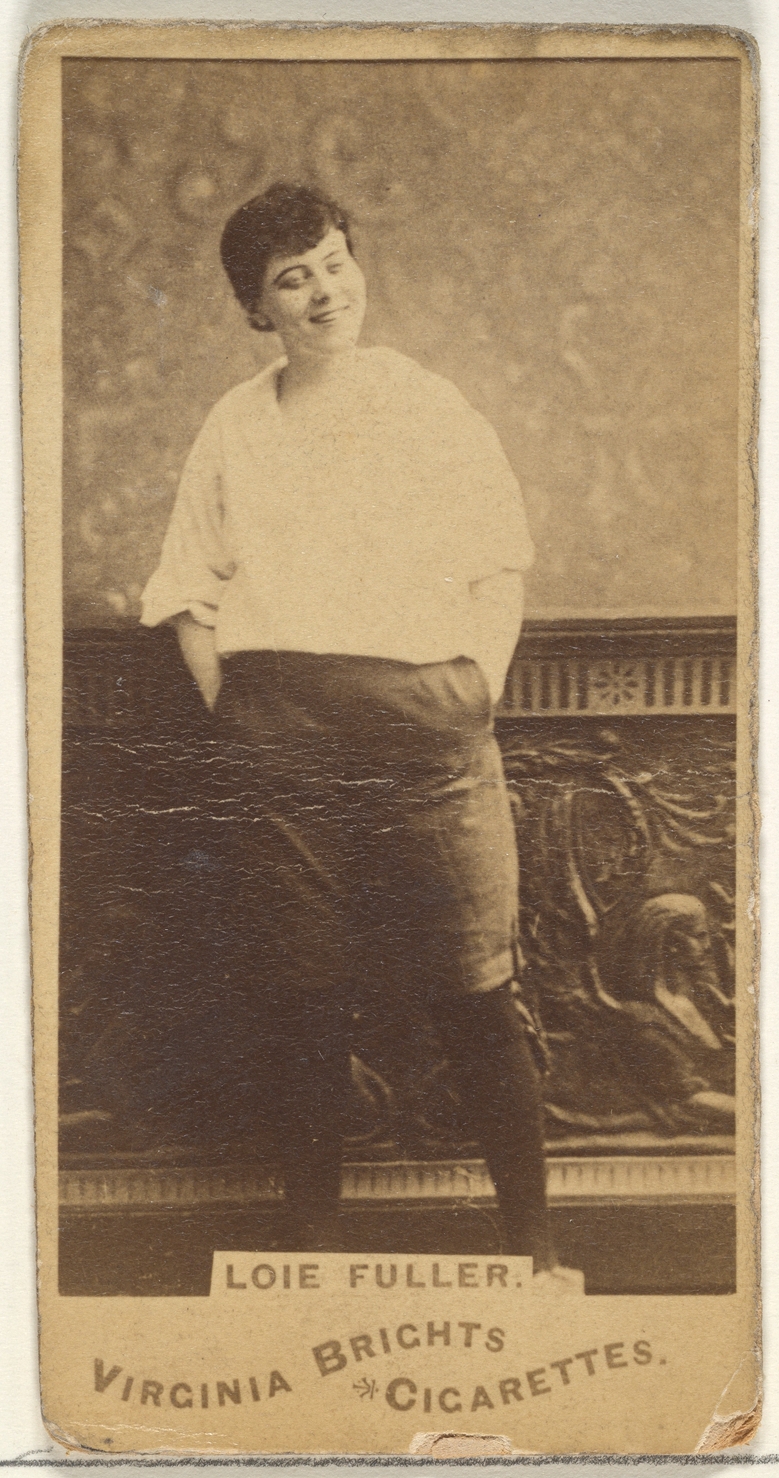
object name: photograph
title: Loie Fuller, from the Actors and Actresses series (N45, Type 1) for Virginia Brights Cigarettes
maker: allen & ginter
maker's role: publisher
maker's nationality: american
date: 1888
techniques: albumen silver print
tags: portraits,women,actresses